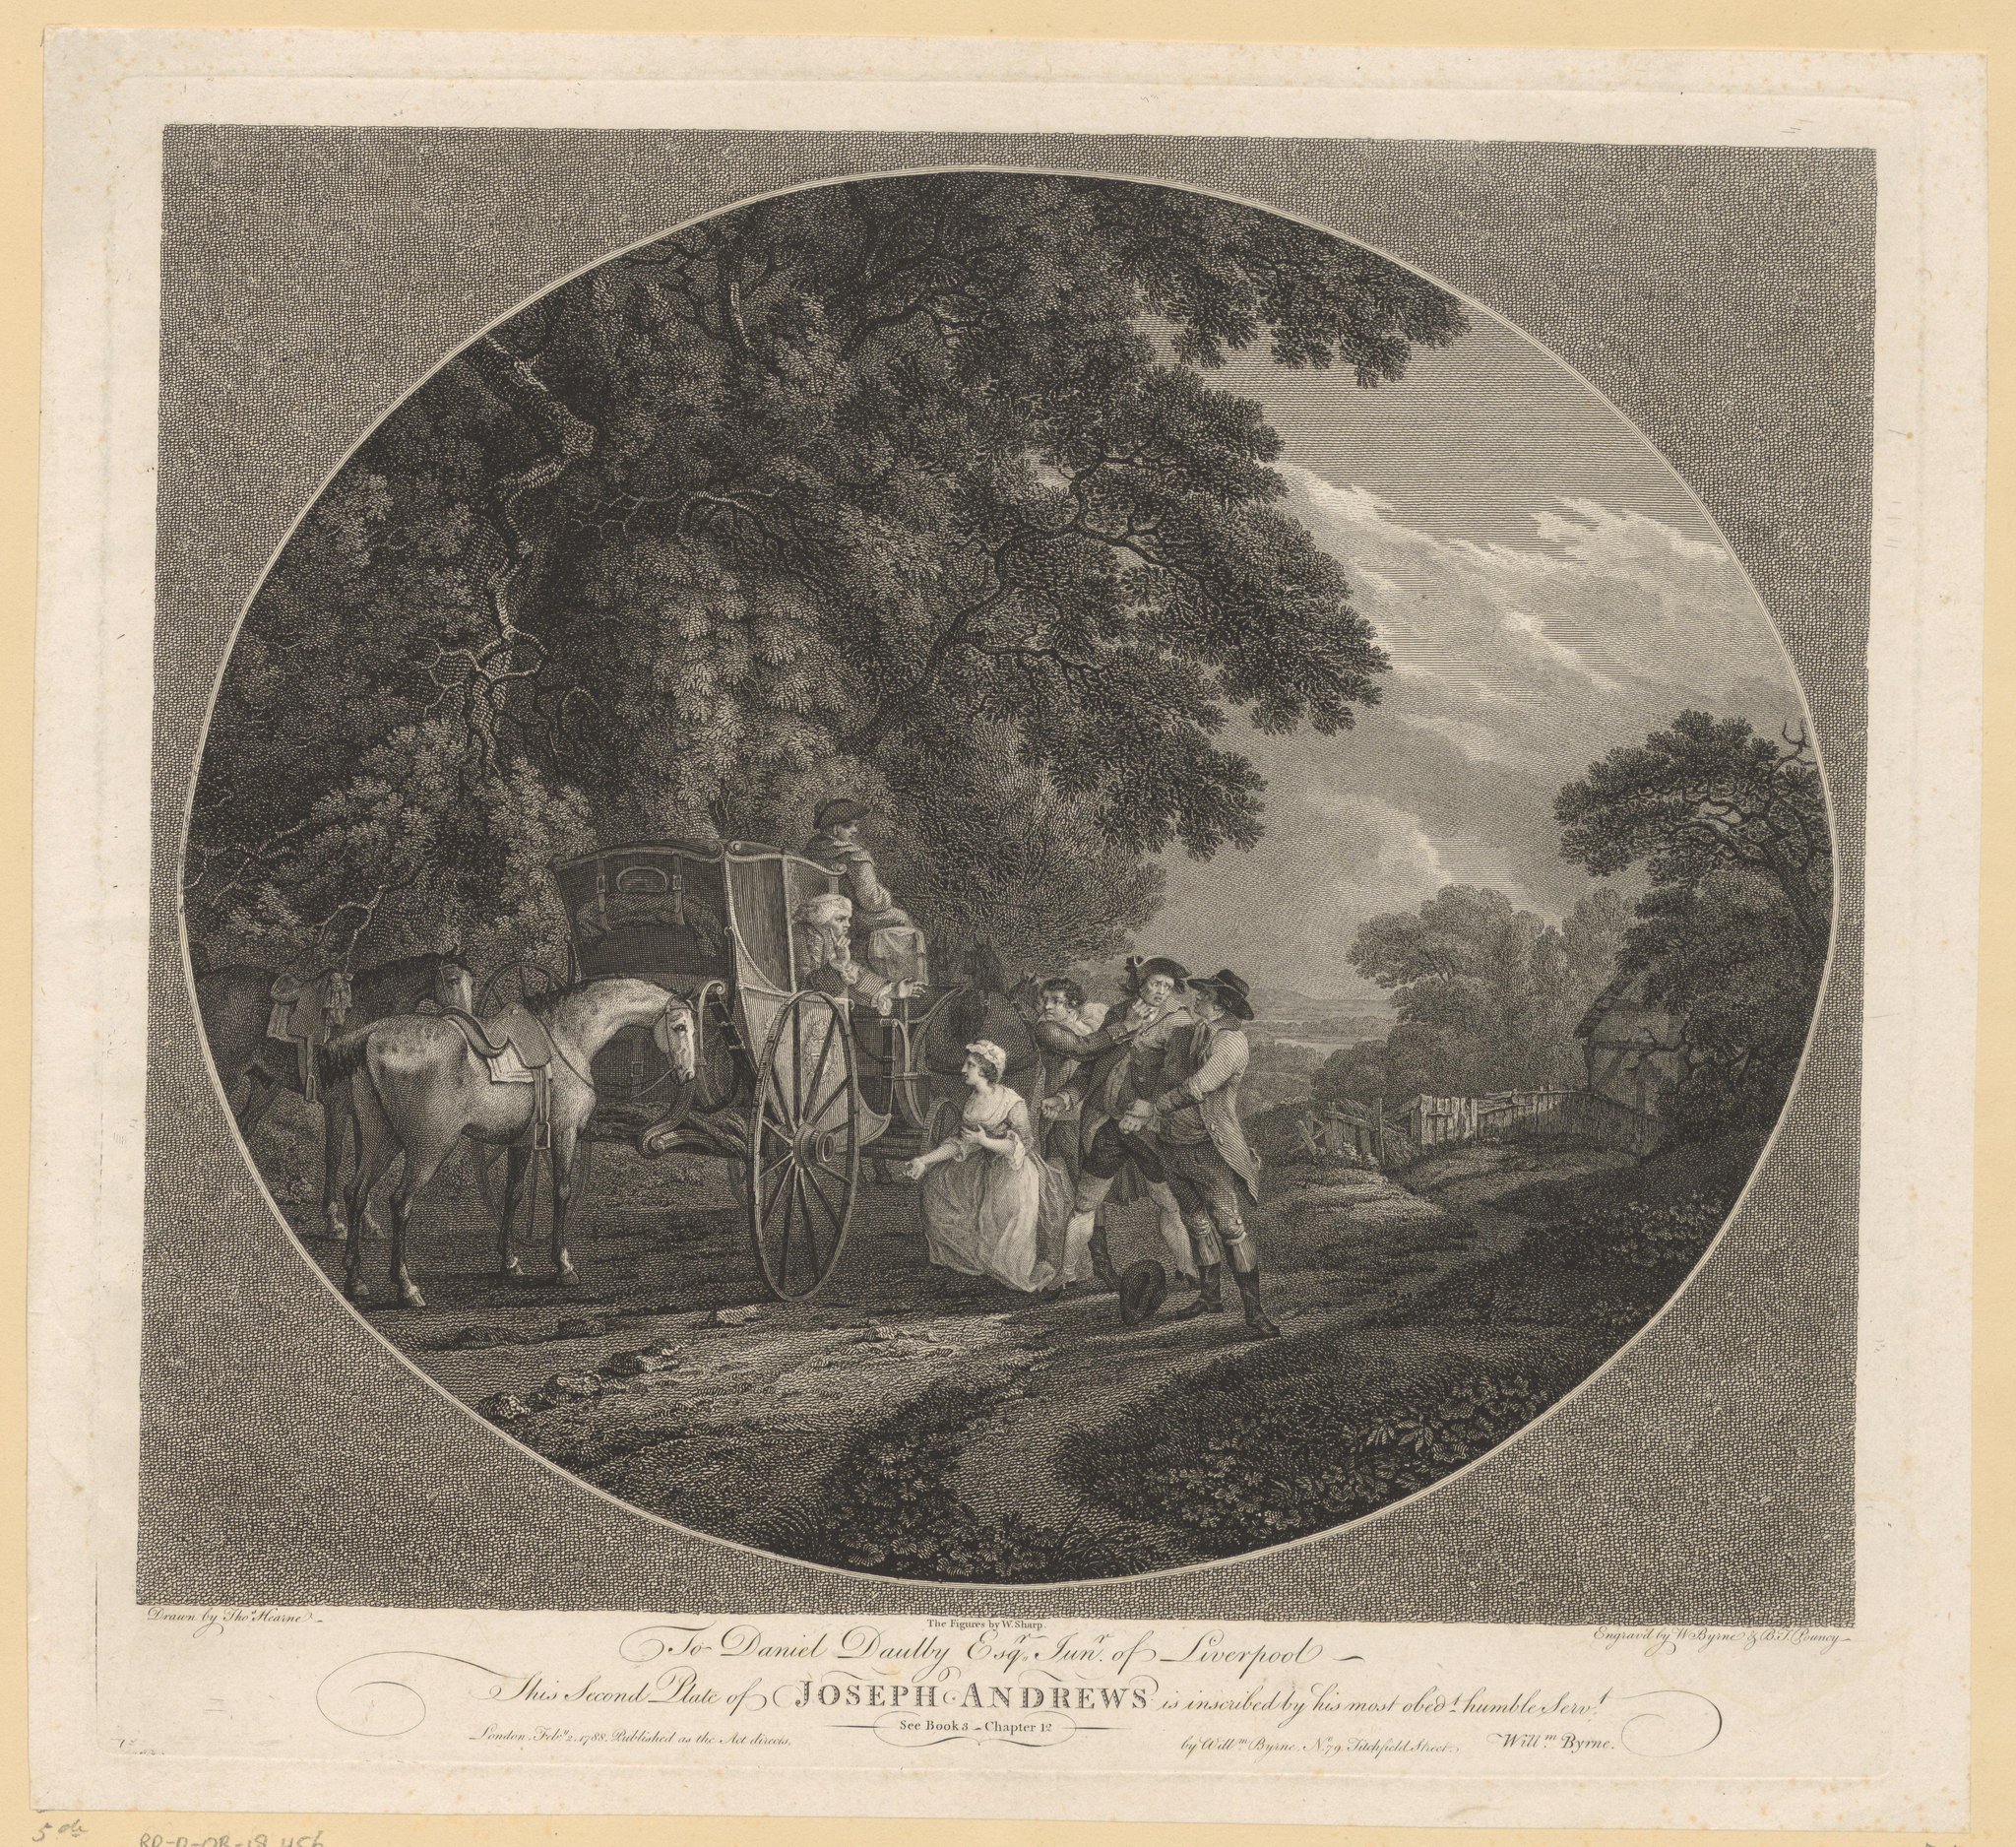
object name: print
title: Fanny Goodwill knielt bij een koets waar Peter Pounce in zit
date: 1702-1788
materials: paper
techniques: etching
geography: london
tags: kneeling figure - aa - female human figure, four-wheeled, animal-drawn vehicle, e.g.: cab, carriage, coach, kidnapping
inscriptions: collector's mark: Lugt 12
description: Scène uit: Fielding, Henry. The History of the Adventures of Joseph Andrews and of his Friend Mr. Abraham Adams. Londen: A. Millar, 1742.